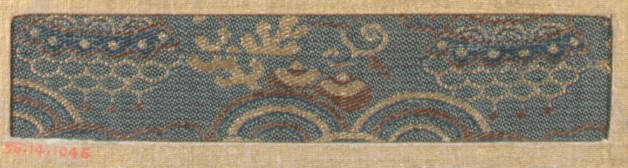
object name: piece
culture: japanese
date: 1701-1900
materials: silk